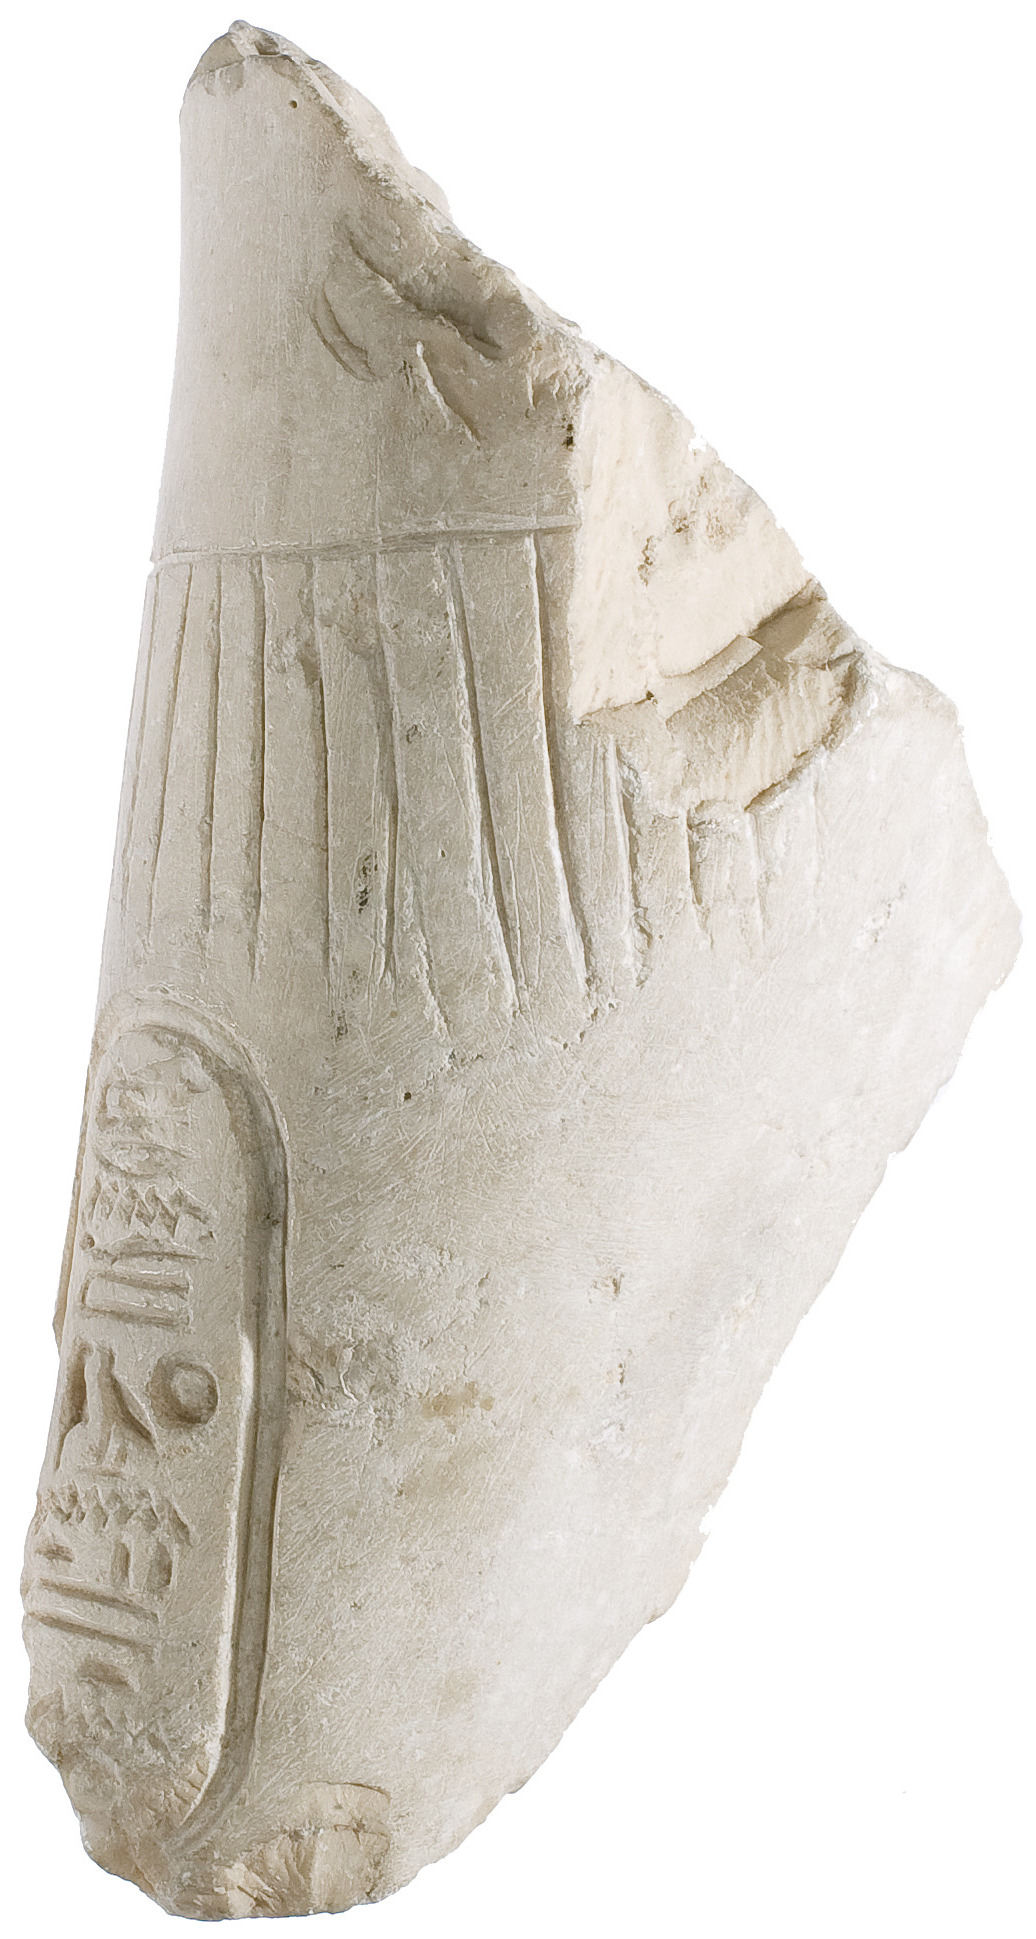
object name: arm with garment fringe, pleating, aten cartouche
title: Left forearm with garment fringe, pleating and Aten cartouche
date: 1353-1336 BCE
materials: limestone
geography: egypt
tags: cartouches,hieroglyphs